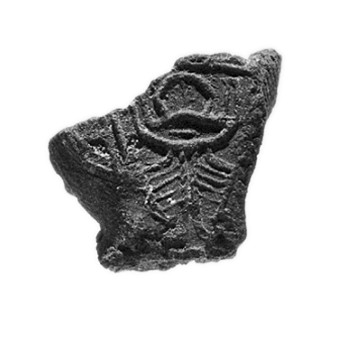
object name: sealing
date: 1981-1640 BCE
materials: mud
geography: egypt